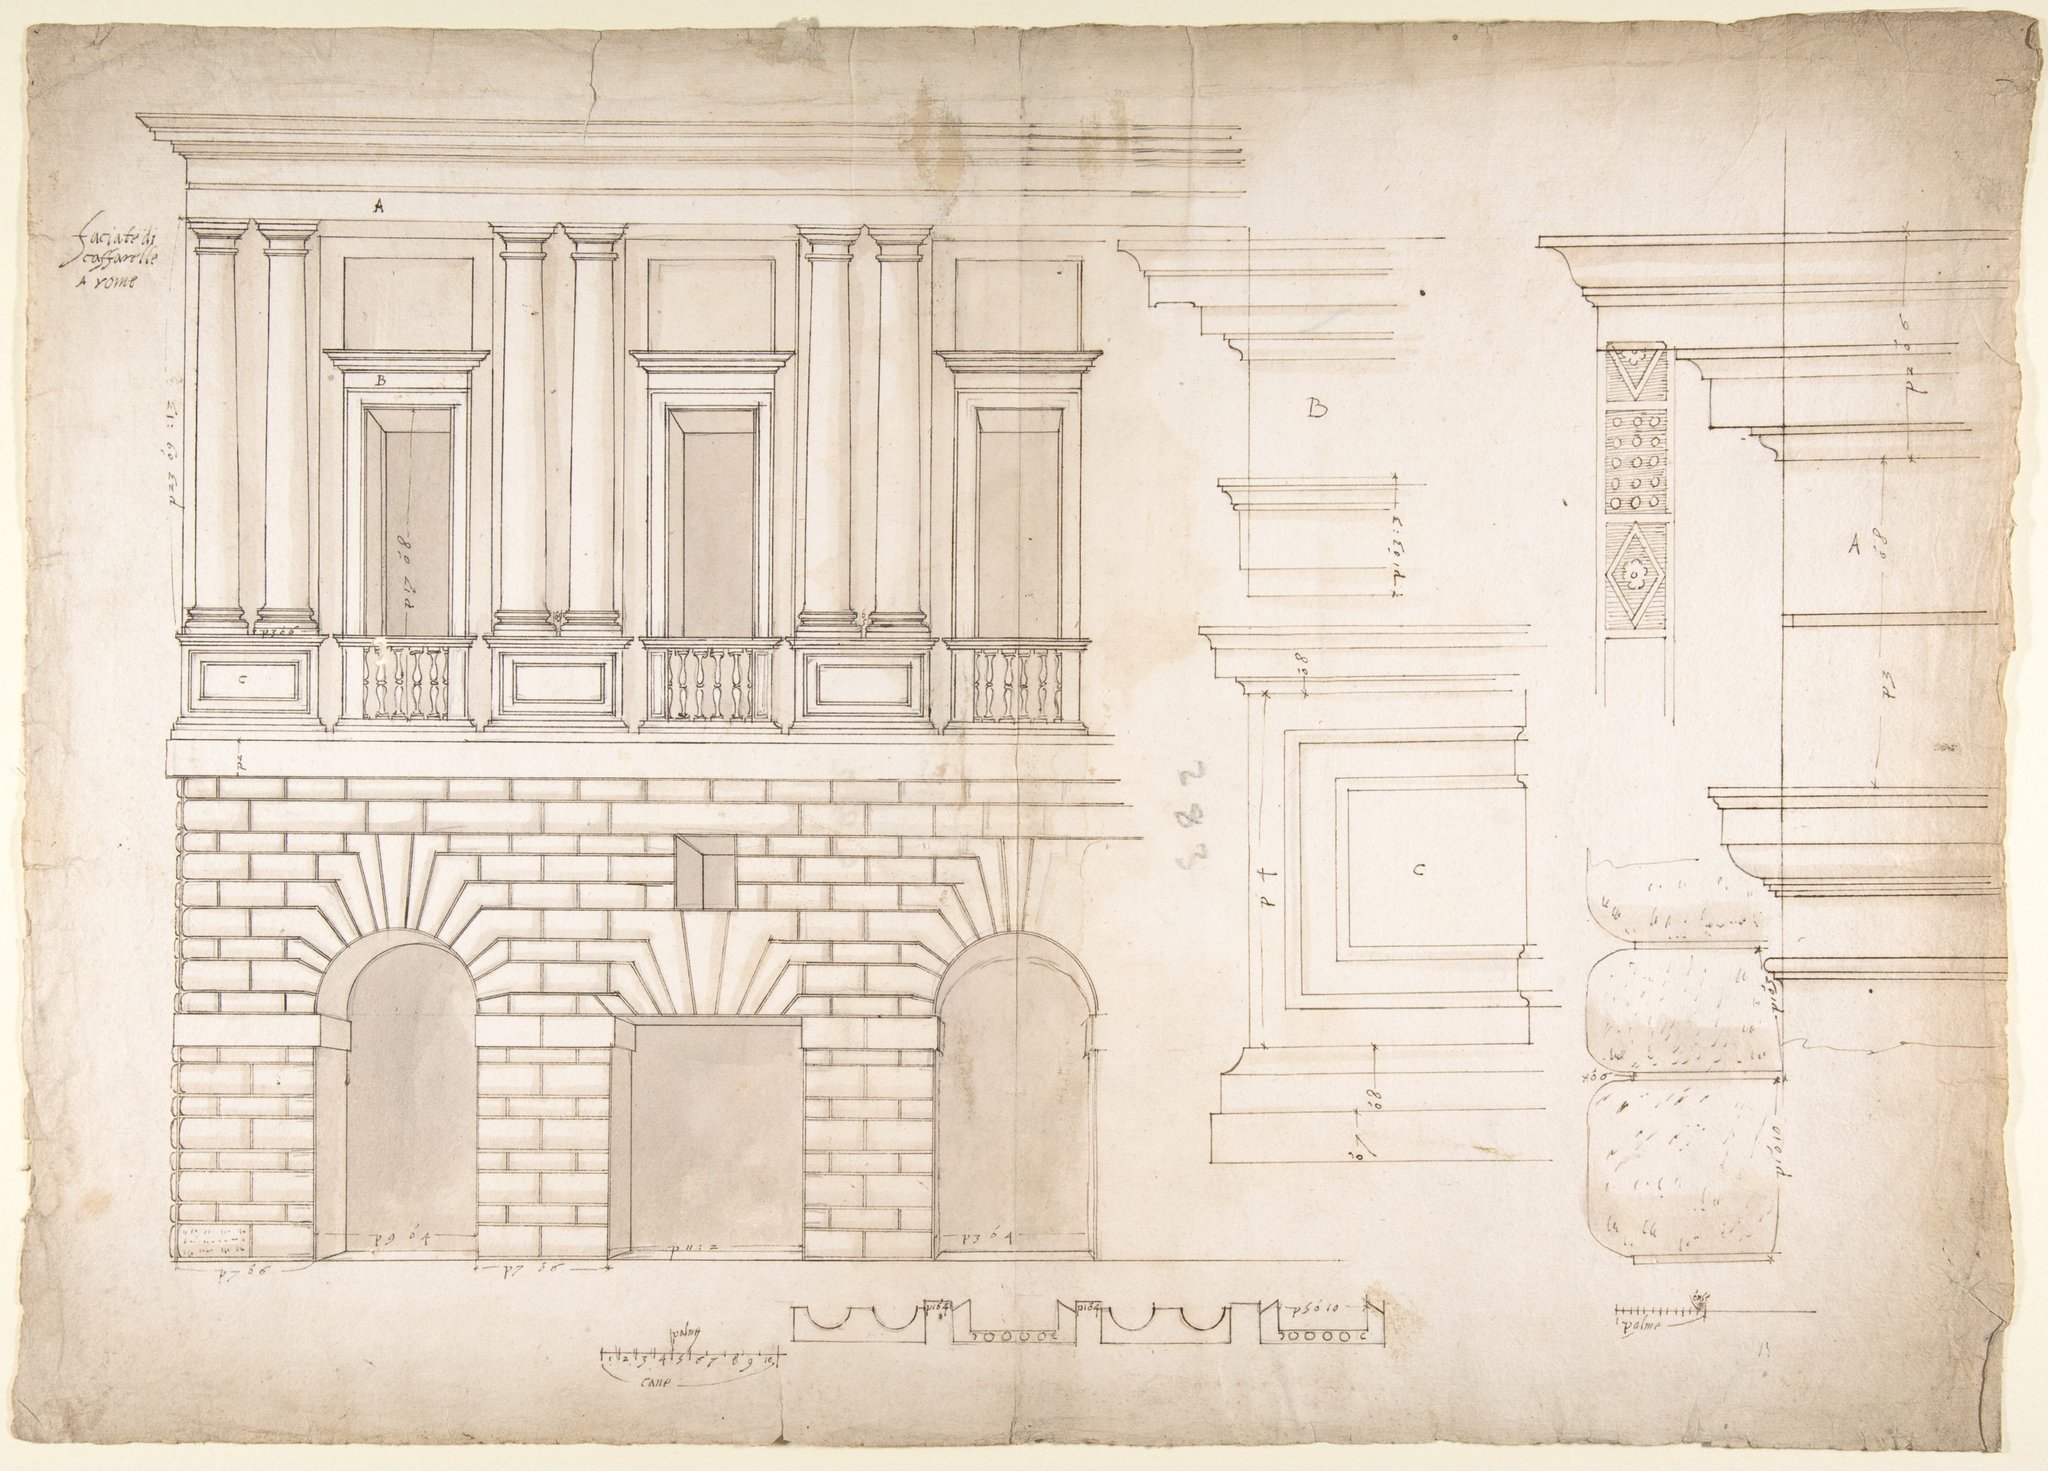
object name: drawing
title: Palazzo Caffarrelli-Vidoni, elevation; details (recto) blank (verso)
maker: anonymous, french, 16th century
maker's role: draftsman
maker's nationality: french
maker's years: 1500-1600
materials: chalk, ink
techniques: incising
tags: architecture